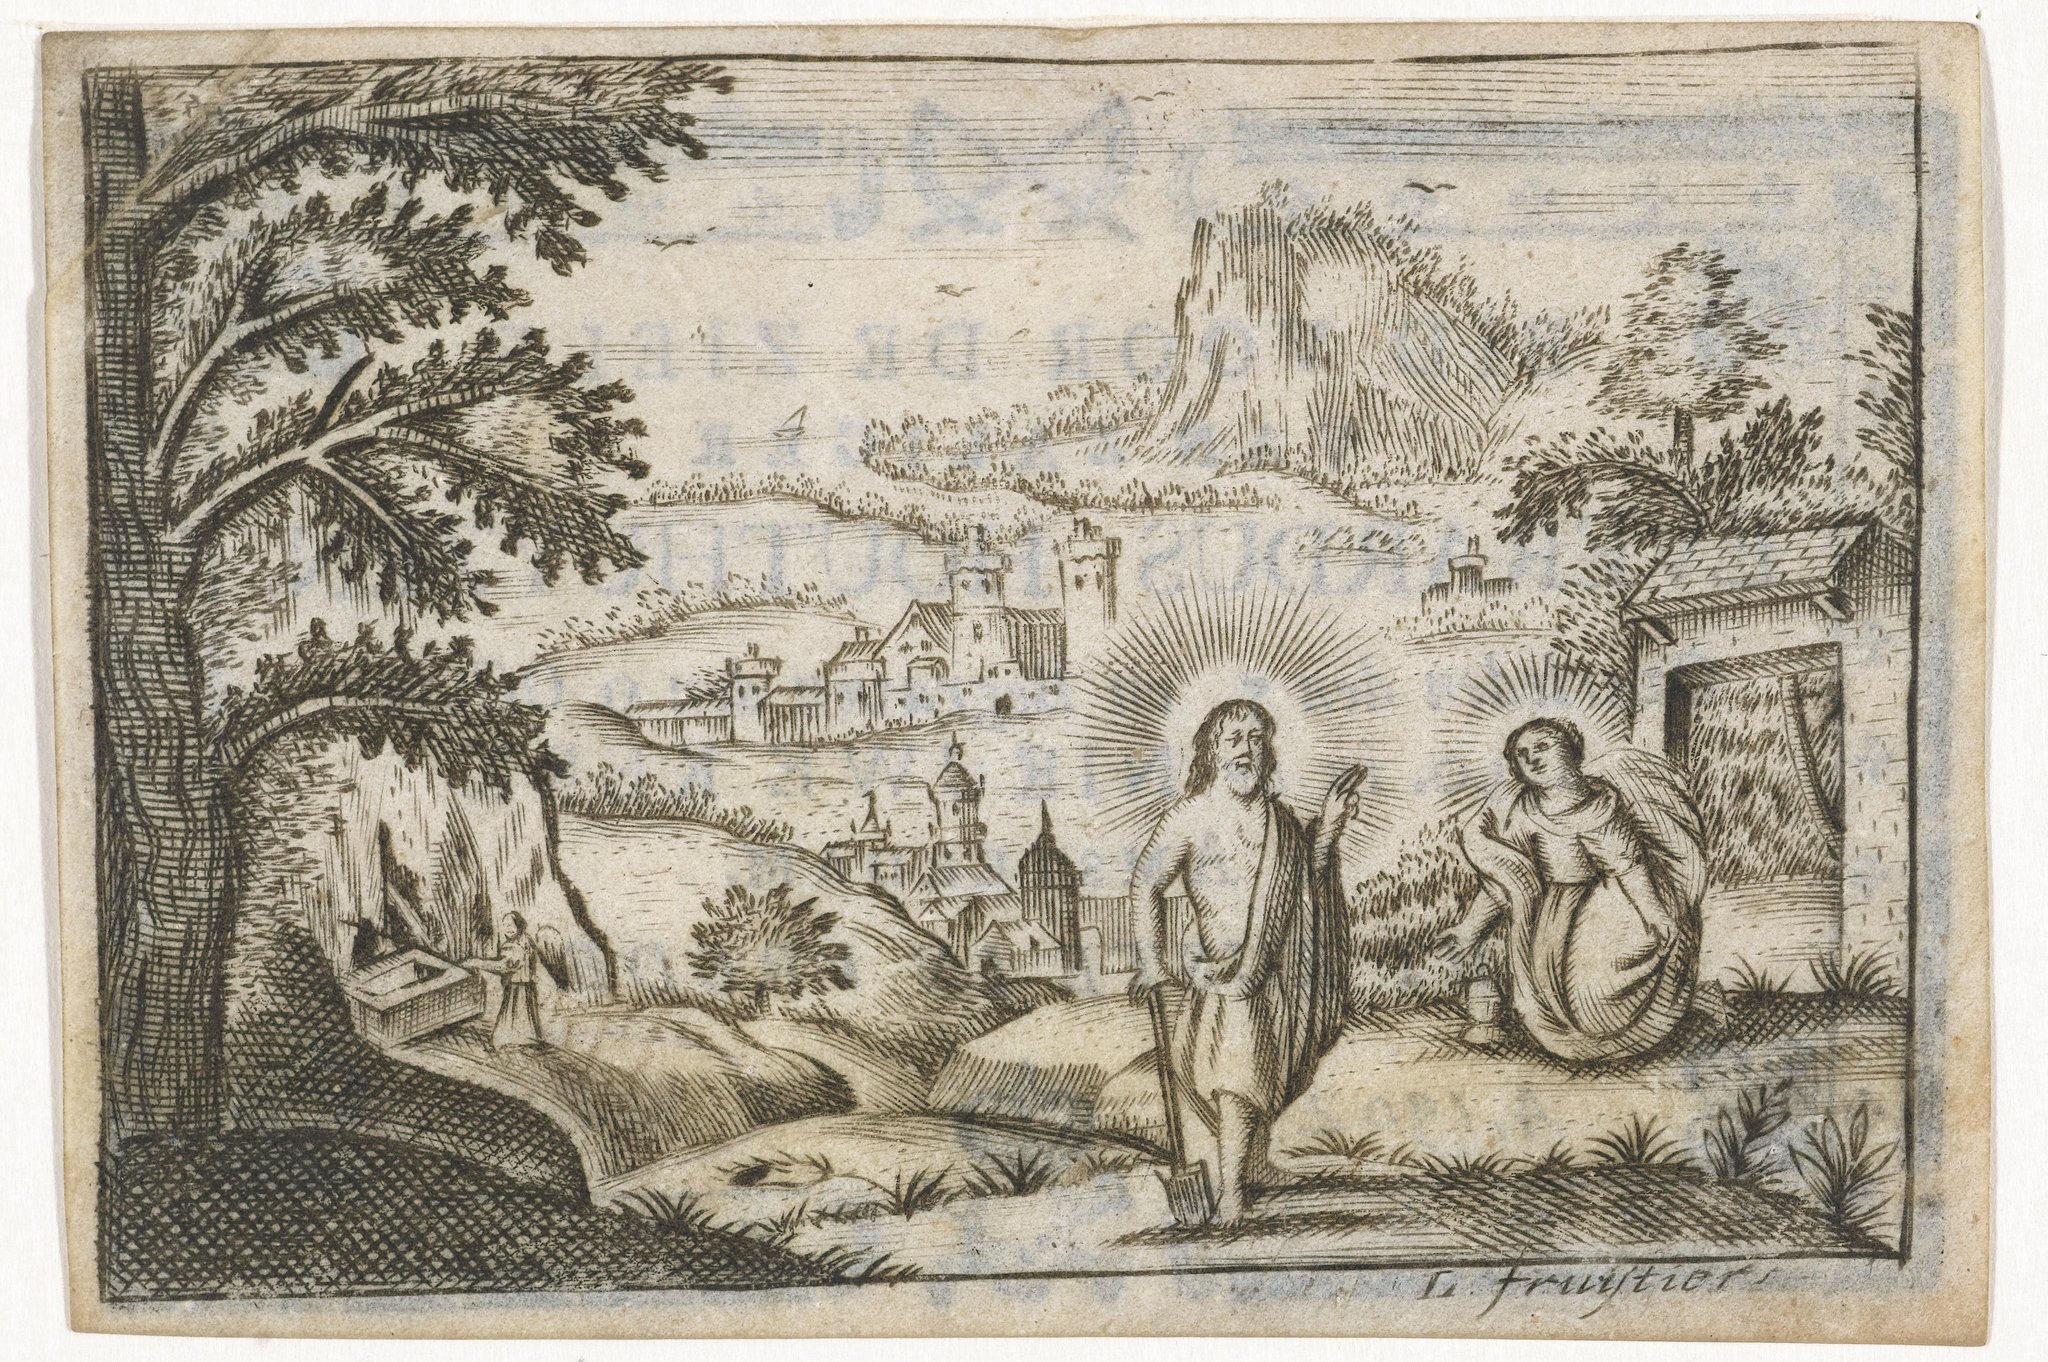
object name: prayer card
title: Christus verschijnt aan Maria Magdalena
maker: lodewijk joseph fruytiers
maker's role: print maker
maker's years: 1713-1782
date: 1723-1782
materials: parchment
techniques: engraving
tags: mary magdalene kneeling before christ, who is usually represented as a gardener with a hoe and/or a spade; 'noli me tangere'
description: Landschap met Christus en Maria Magdalena. Christus maakt een zegenend gebaar naar Magdalena die in geknielde houding voor hem zit. Op de achtergrond een engel. Verso een bidprent voor Everardus Houthuyzen uit Amsterdam, overleden in 1790.